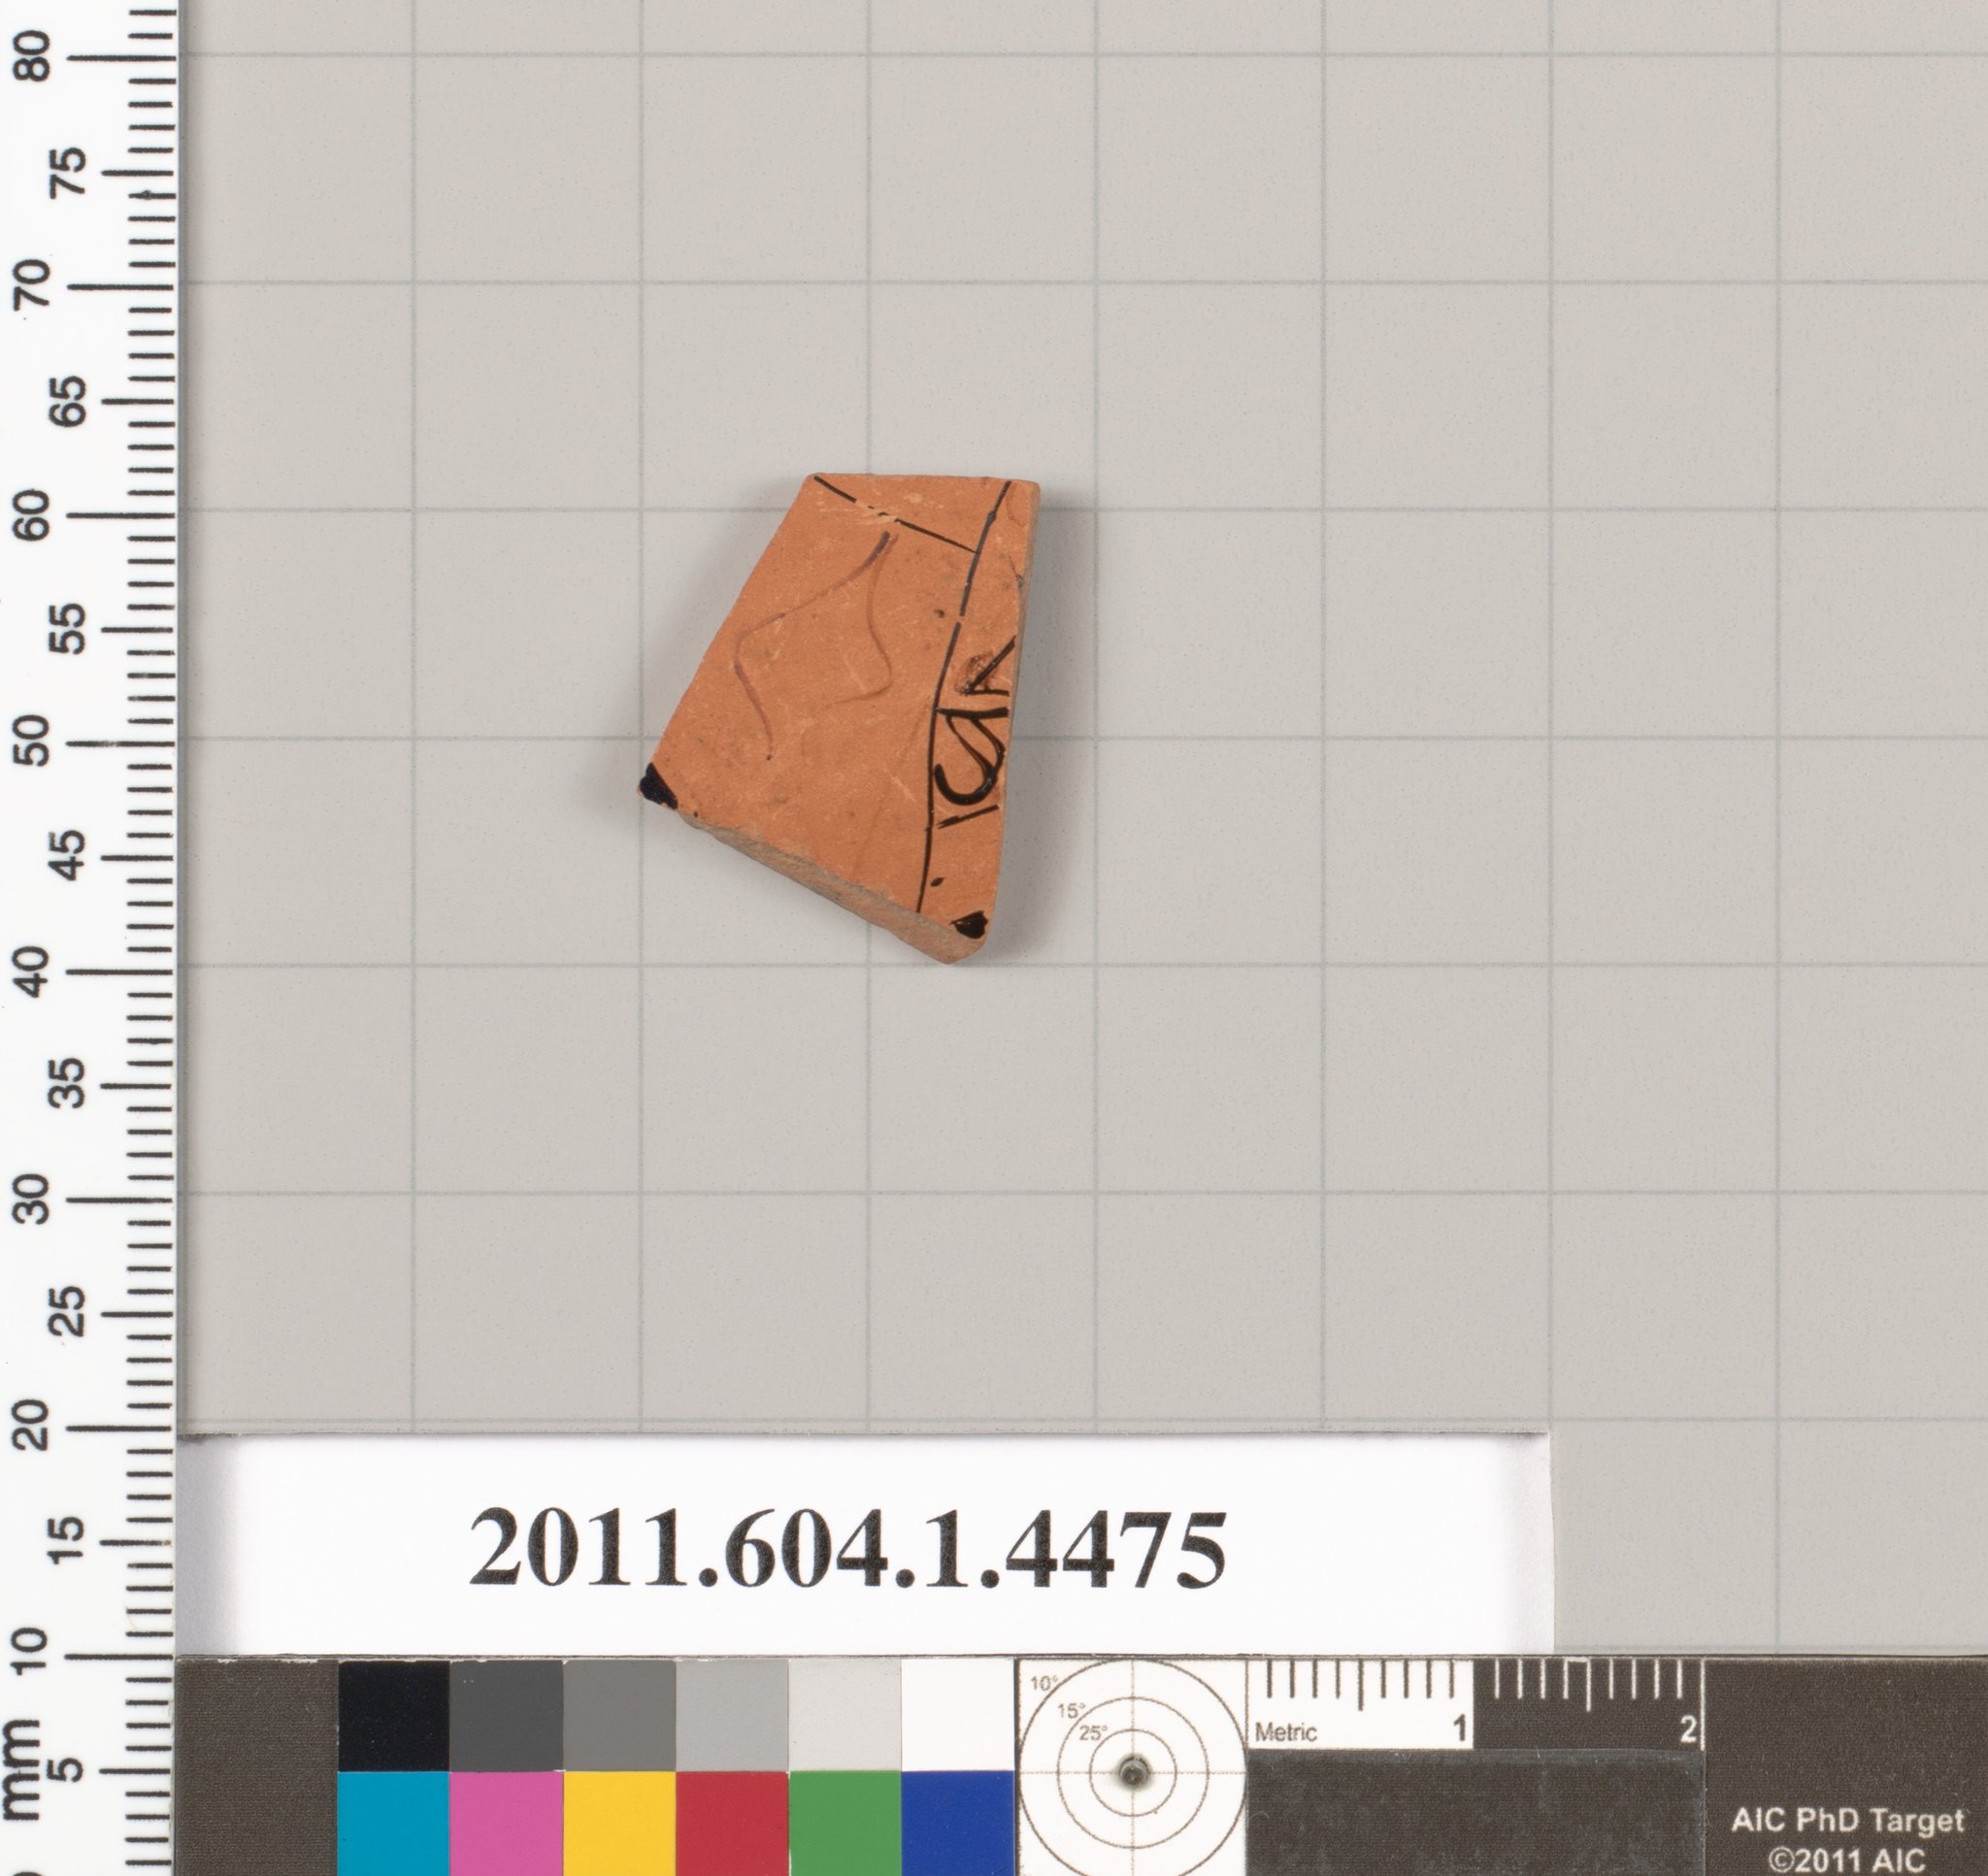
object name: kylix fragment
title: Terracotta fragment of a kylix (drinking cup)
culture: greek, attic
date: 490-470 BCE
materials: terracotta